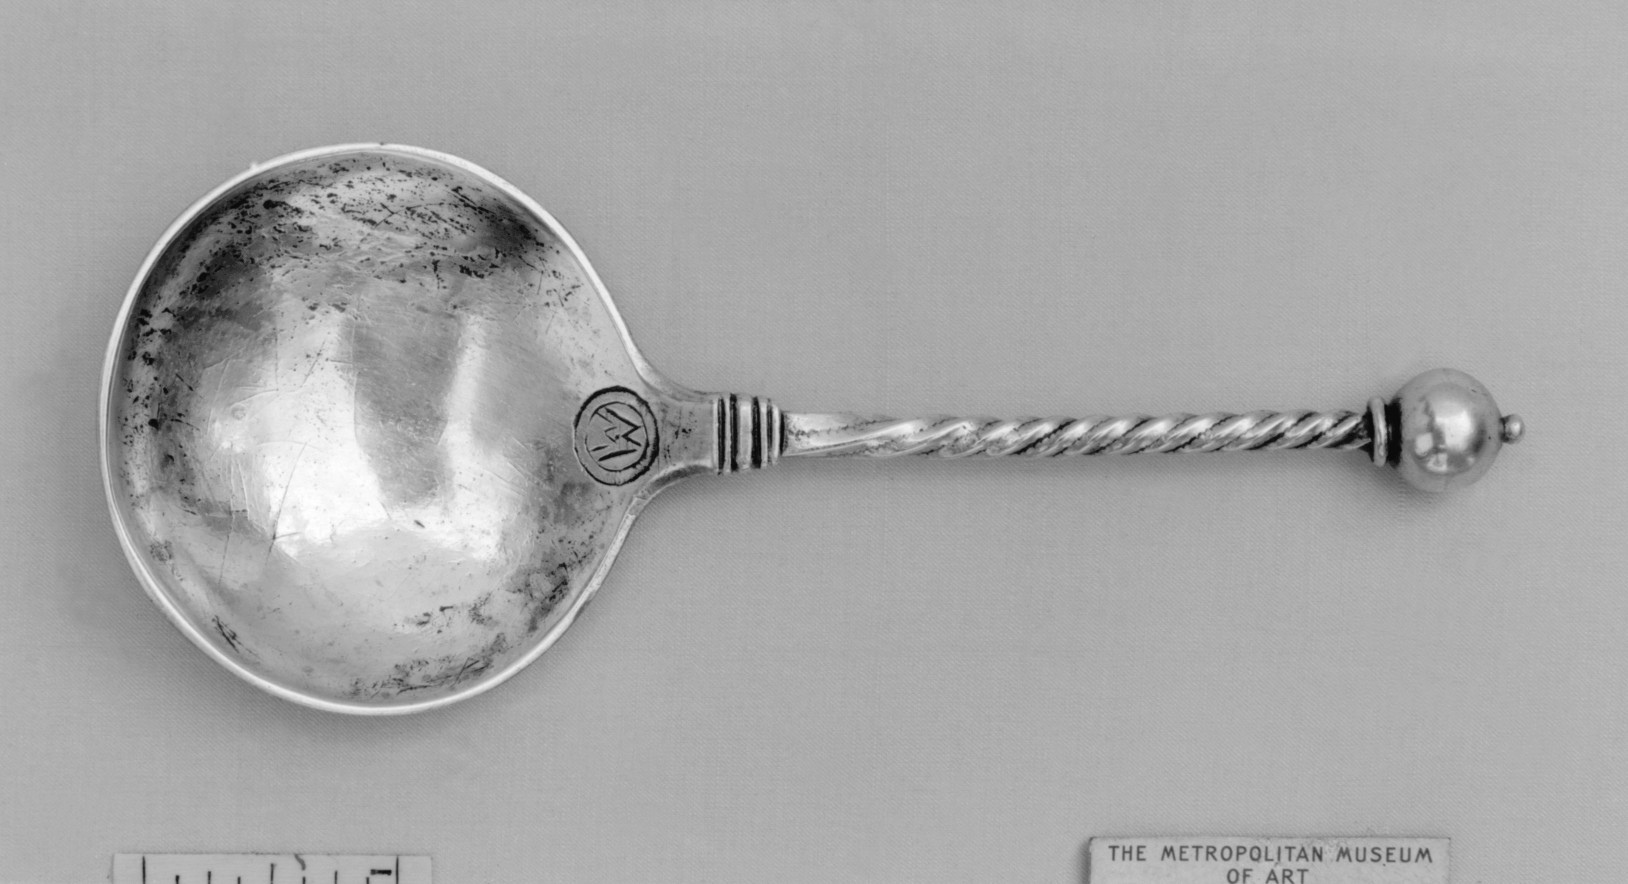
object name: spoon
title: Ball-knopped spoon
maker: hans möller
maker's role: maker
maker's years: 1612-1663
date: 1634-1666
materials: silver